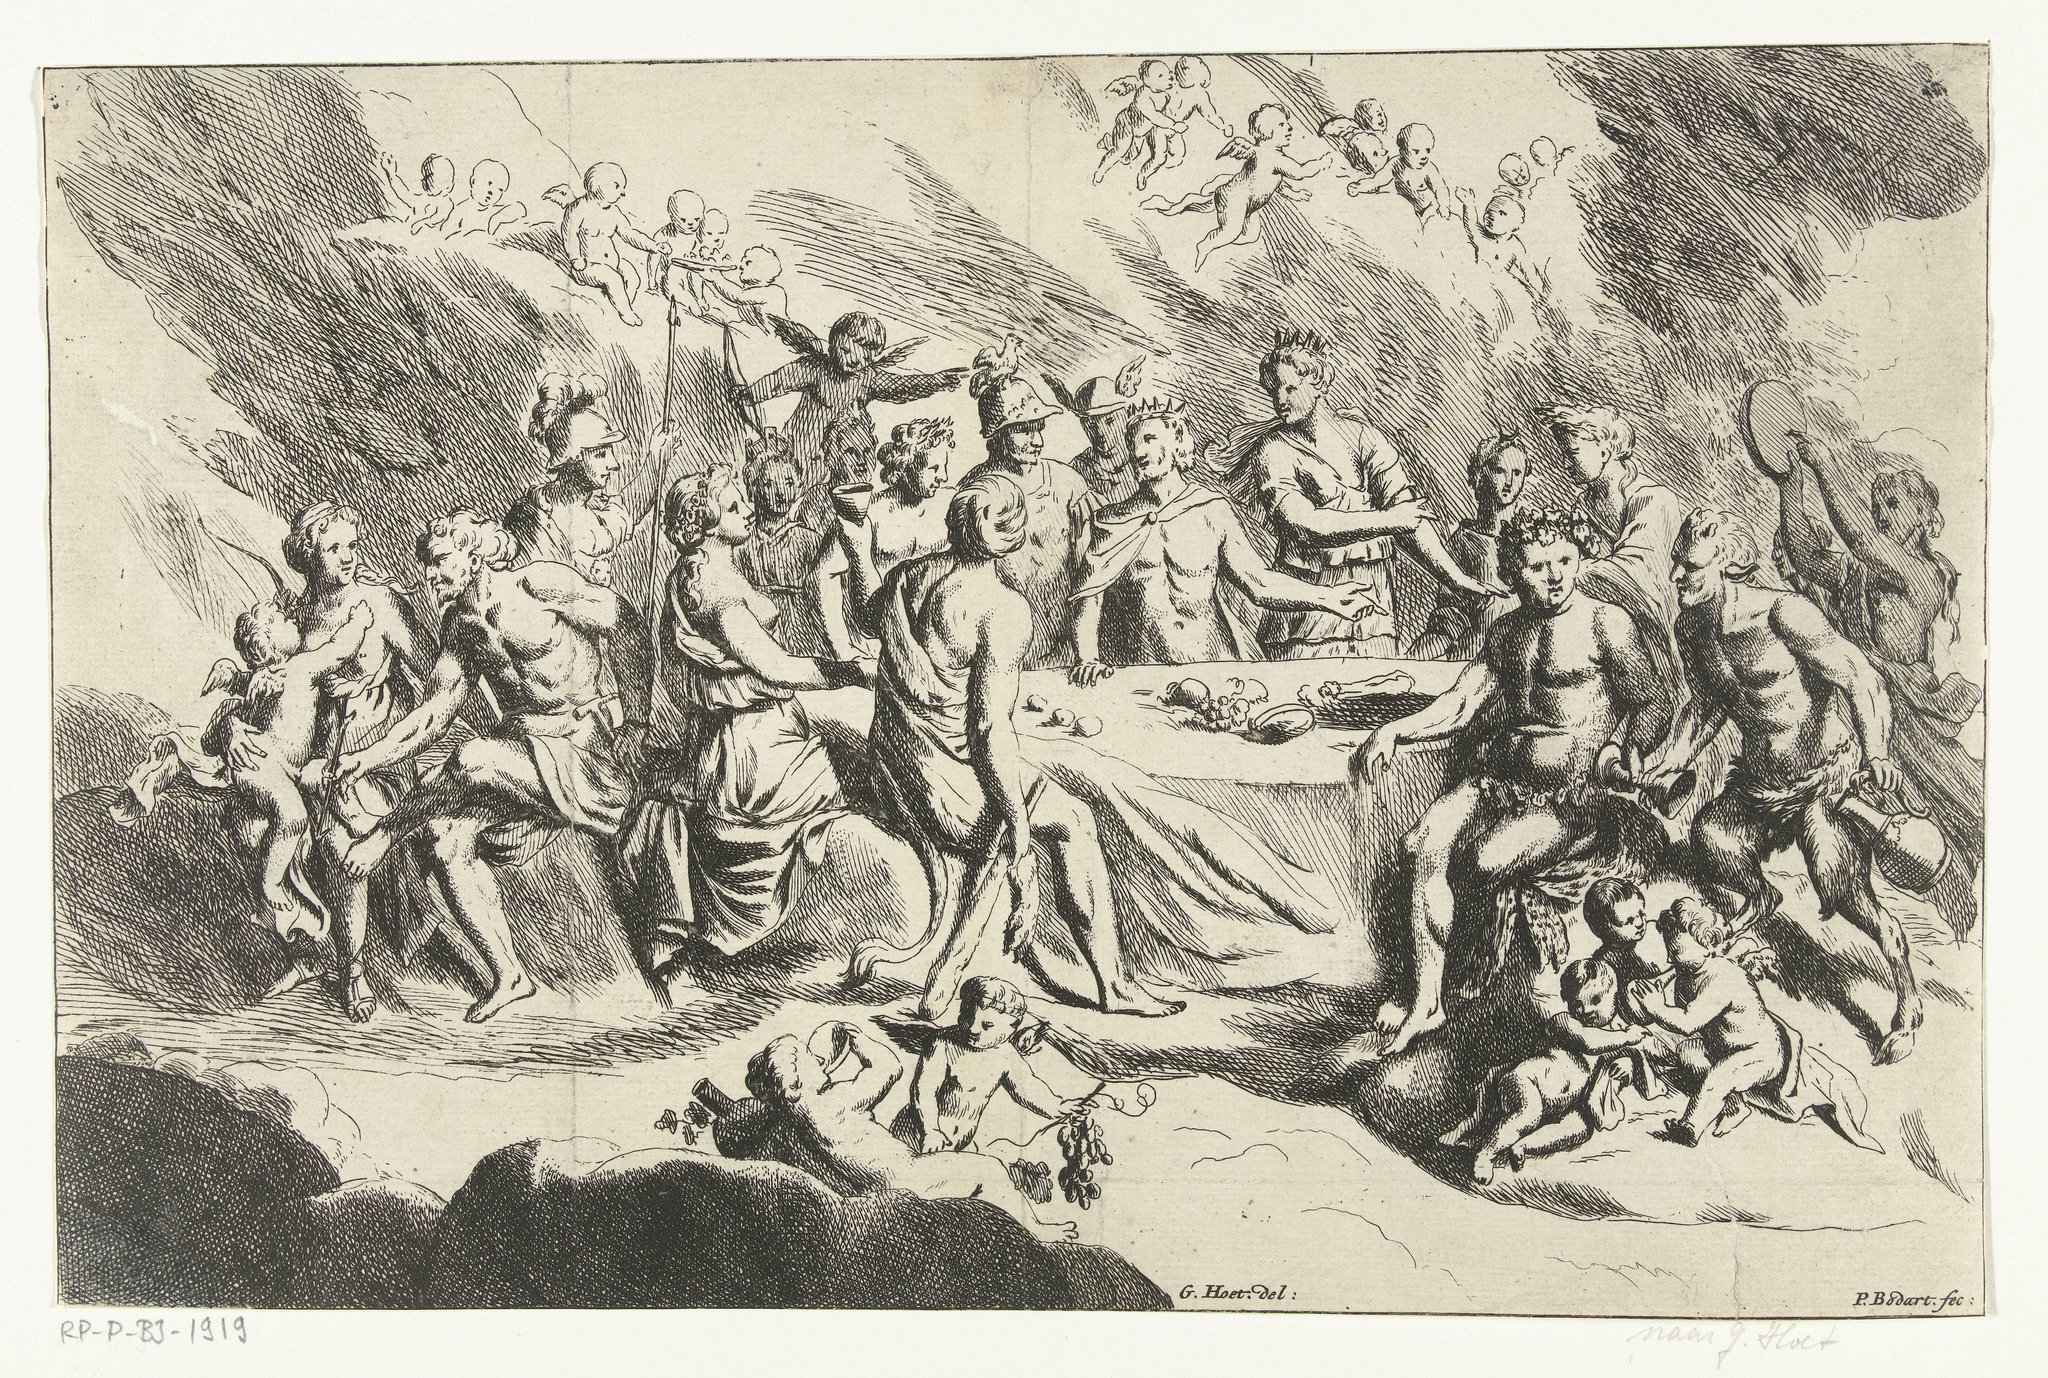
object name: book illustration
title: Feestmaal in de Olympus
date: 1723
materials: paper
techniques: etching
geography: netherlands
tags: the olympian gods together: jupiter, juno, neptune, ceres, apollo, diana, mars, venus, mercury, minerva, vulcan, vesta (or bacchus)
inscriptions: collector's mark: Lugt 2228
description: De goden zitten aan tafel tijdens een feestmaal in de Olympus. Jupiter en Juno de oppergoden dragen kronen. Ook een aantal andere goden zijn aan hun attributen te herkennen. Links zit Venus, Amor kruipt op haar schoot. Naast haar zit Vulcanus met een hamer in zijn hand. Achter hen staat Minerva. Op de voorgrond heft Hercules zijn glas, te herkennen aan de knots en de leeuwenhuid. Achter Jupiter staat Mercurius, en naast Juno zit Diana.